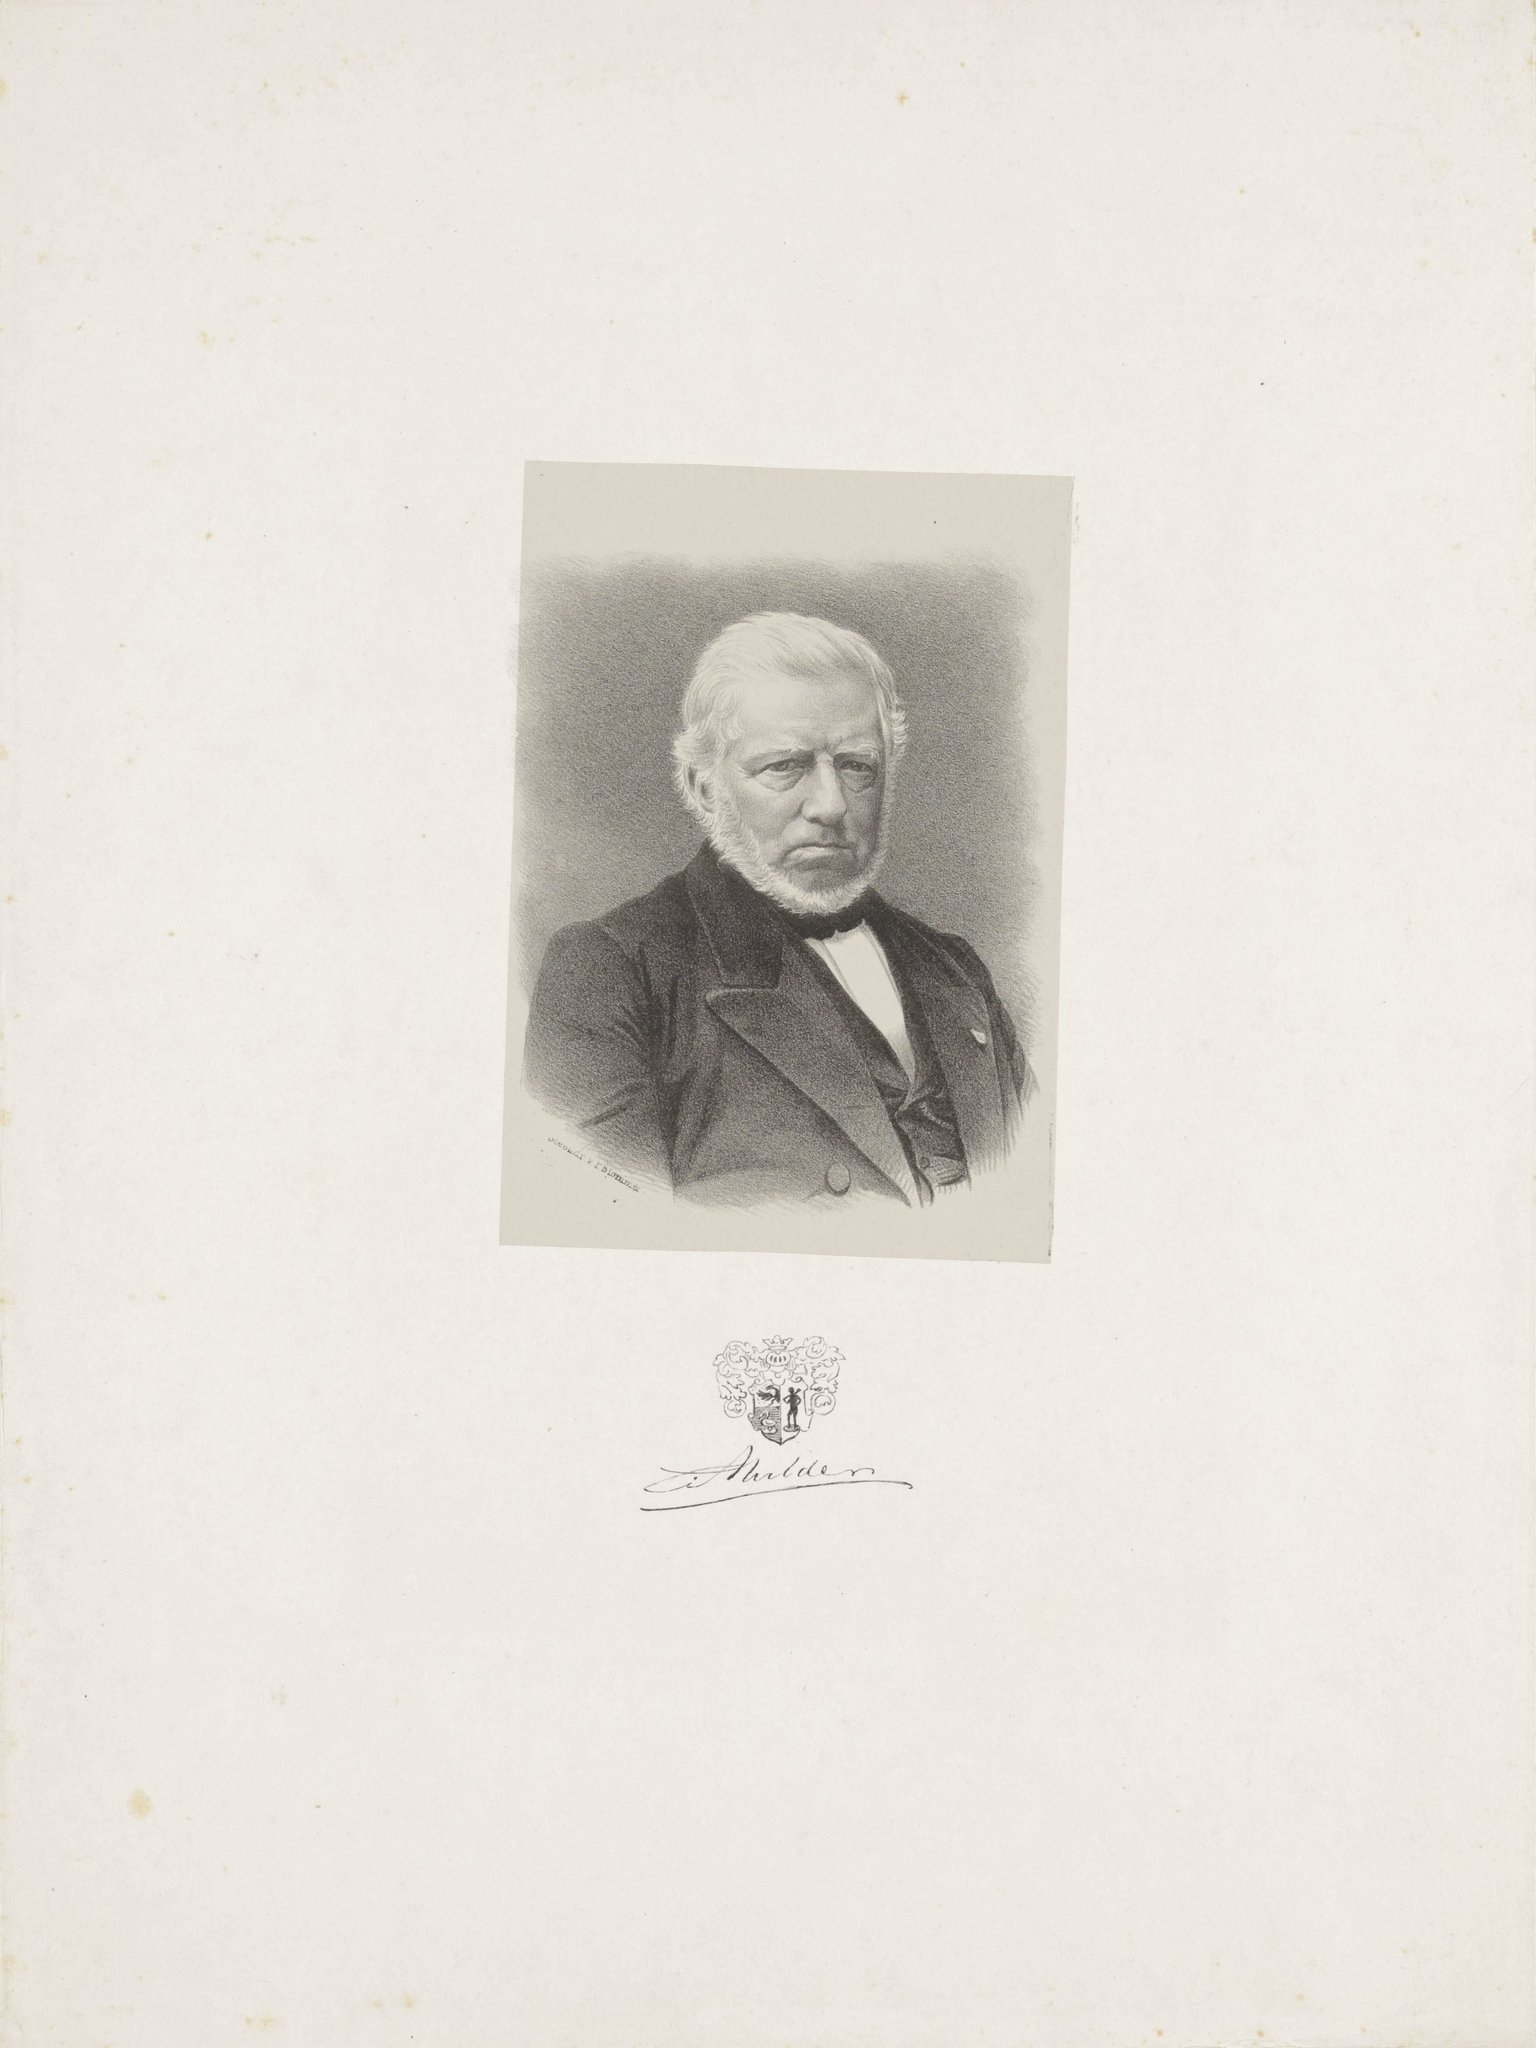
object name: print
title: Portret van A. Mulder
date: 1842-1887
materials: paper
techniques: lithograph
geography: the hague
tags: historical persons (+ head (and shoulders) (portrait)), armorial bearing, heraldry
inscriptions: collector's mark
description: De geportretteerde heeft een grijze ringbaard. Onder het portret zijn familiewapen en signatuur.